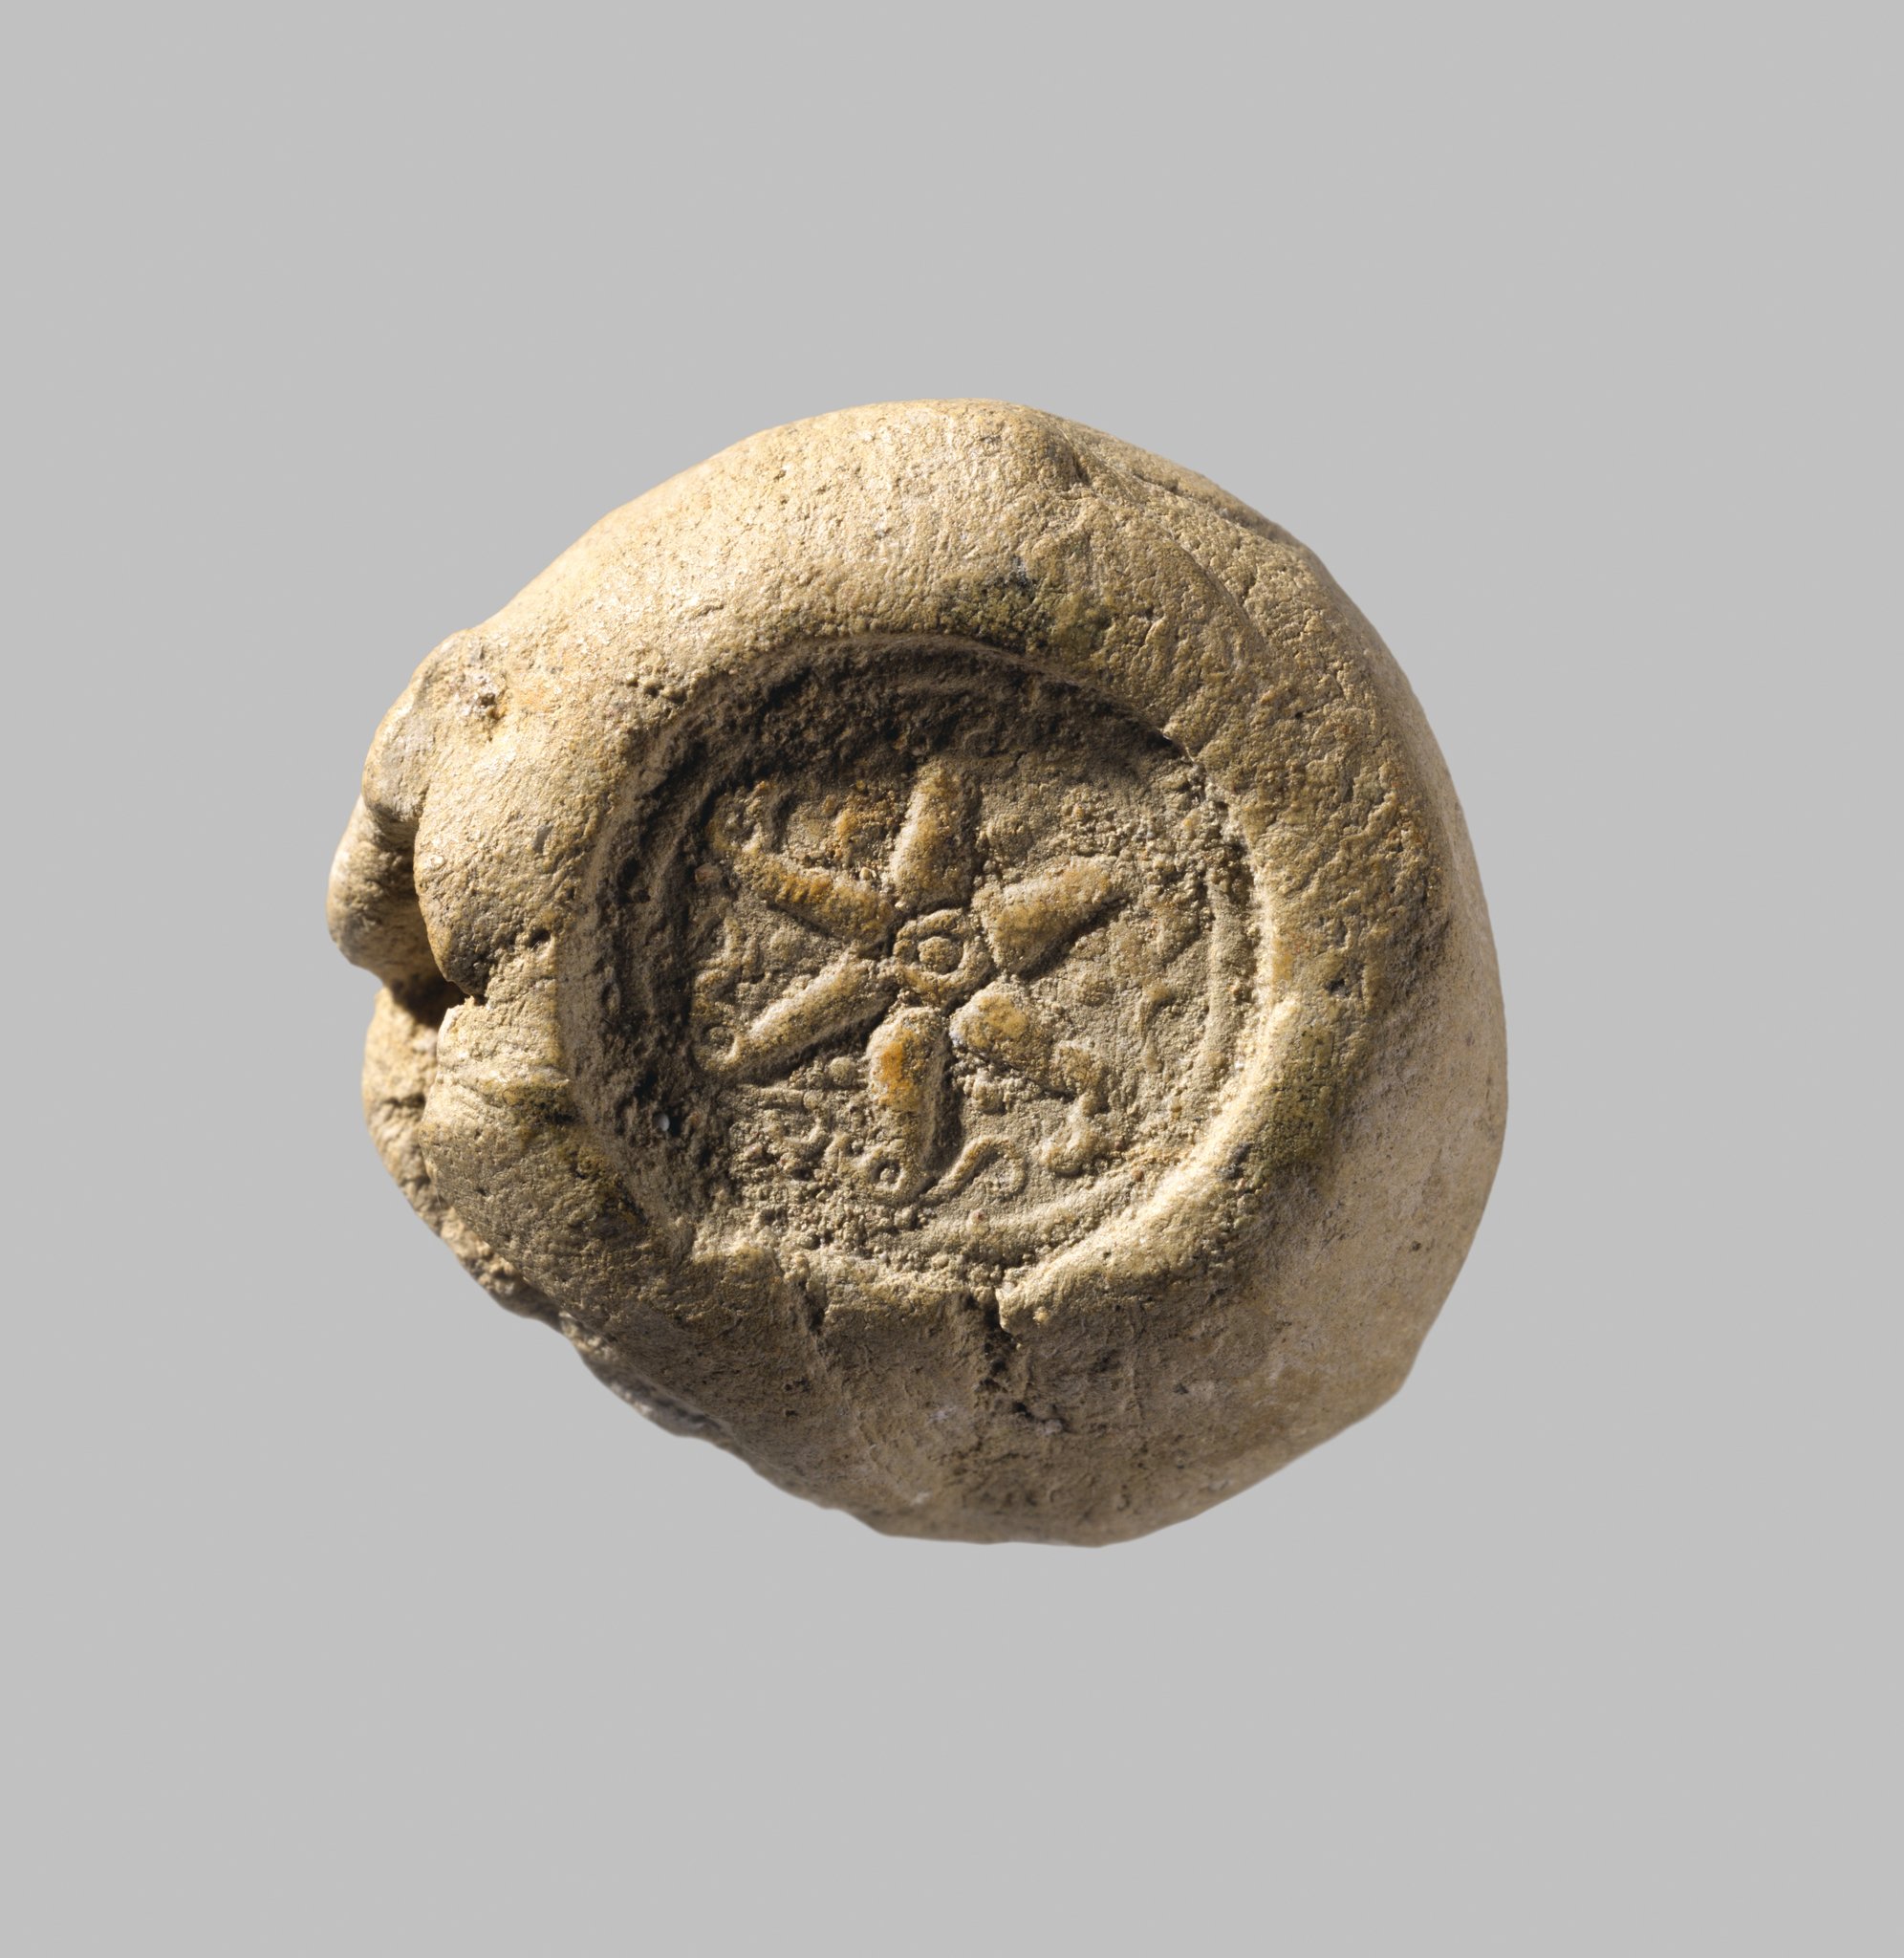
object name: sealing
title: Sealing with stamp seal impressions: radiating griffins; banquet scene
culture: assyrian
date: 1800-1701 BCE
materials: ceramic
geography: anatolia